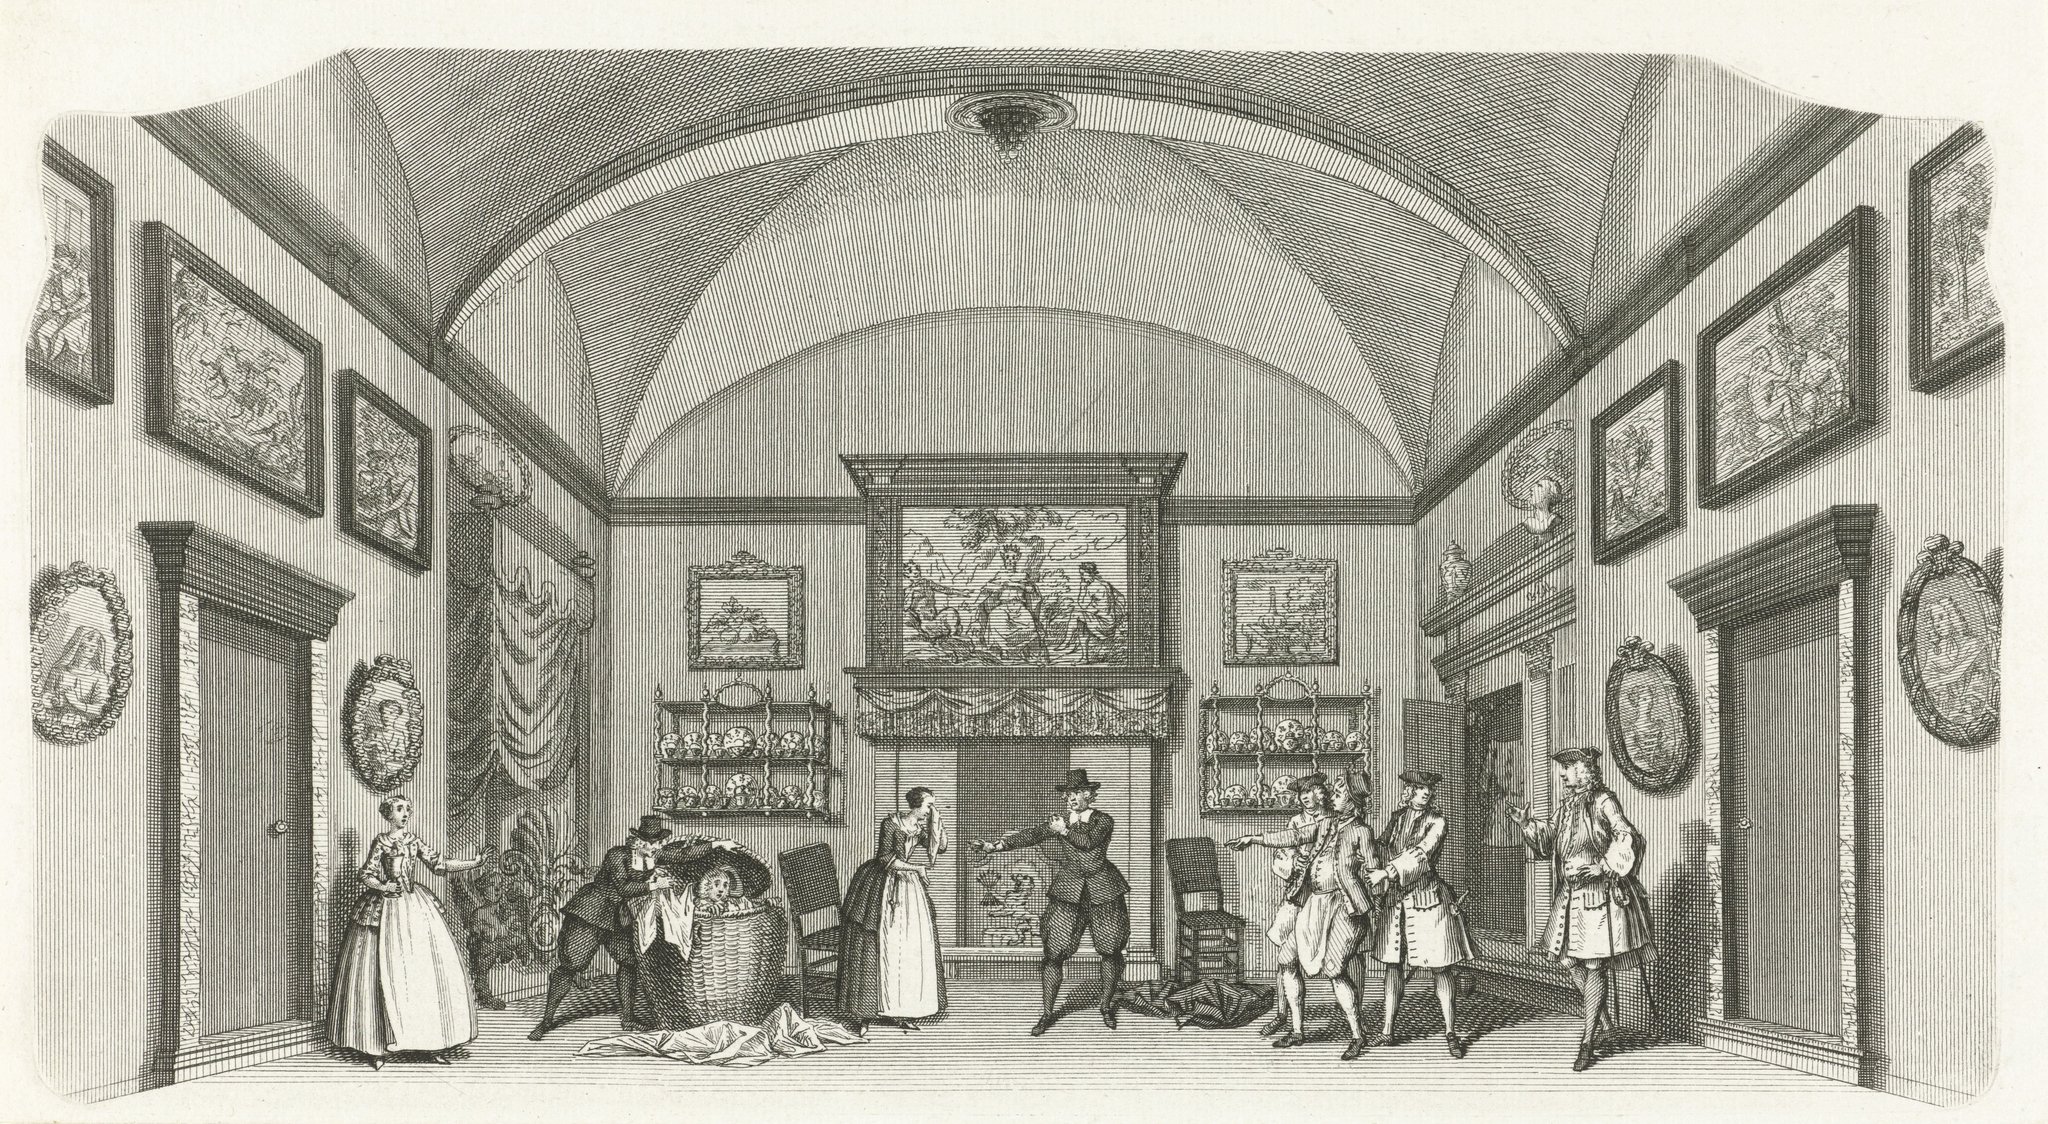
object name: print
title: Toneeldecors van de Amsterdamse Schouwburg, ca. 1760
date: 1736-1738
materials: paper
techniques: engraving, etching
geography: amsterdam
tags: theatre, theatrical performance, stage design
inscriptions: collector's mark: Lugt 2228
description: Scène uit het toneelstuk "De ontdekte schyndeugd, bly-spel" door David Lingelbach, Amsterdam 1687. Deze platen zijn in verschillende groepen in verschillende periodes vervaardigd tussen 1738-1760 en uitgegeven in verschillende series ca. 1760 en ca. 1770-1772. De platen zijn door Muller ingedeeld bij de platen van de brand van de Amsterdamse Schouwburg in 1772.